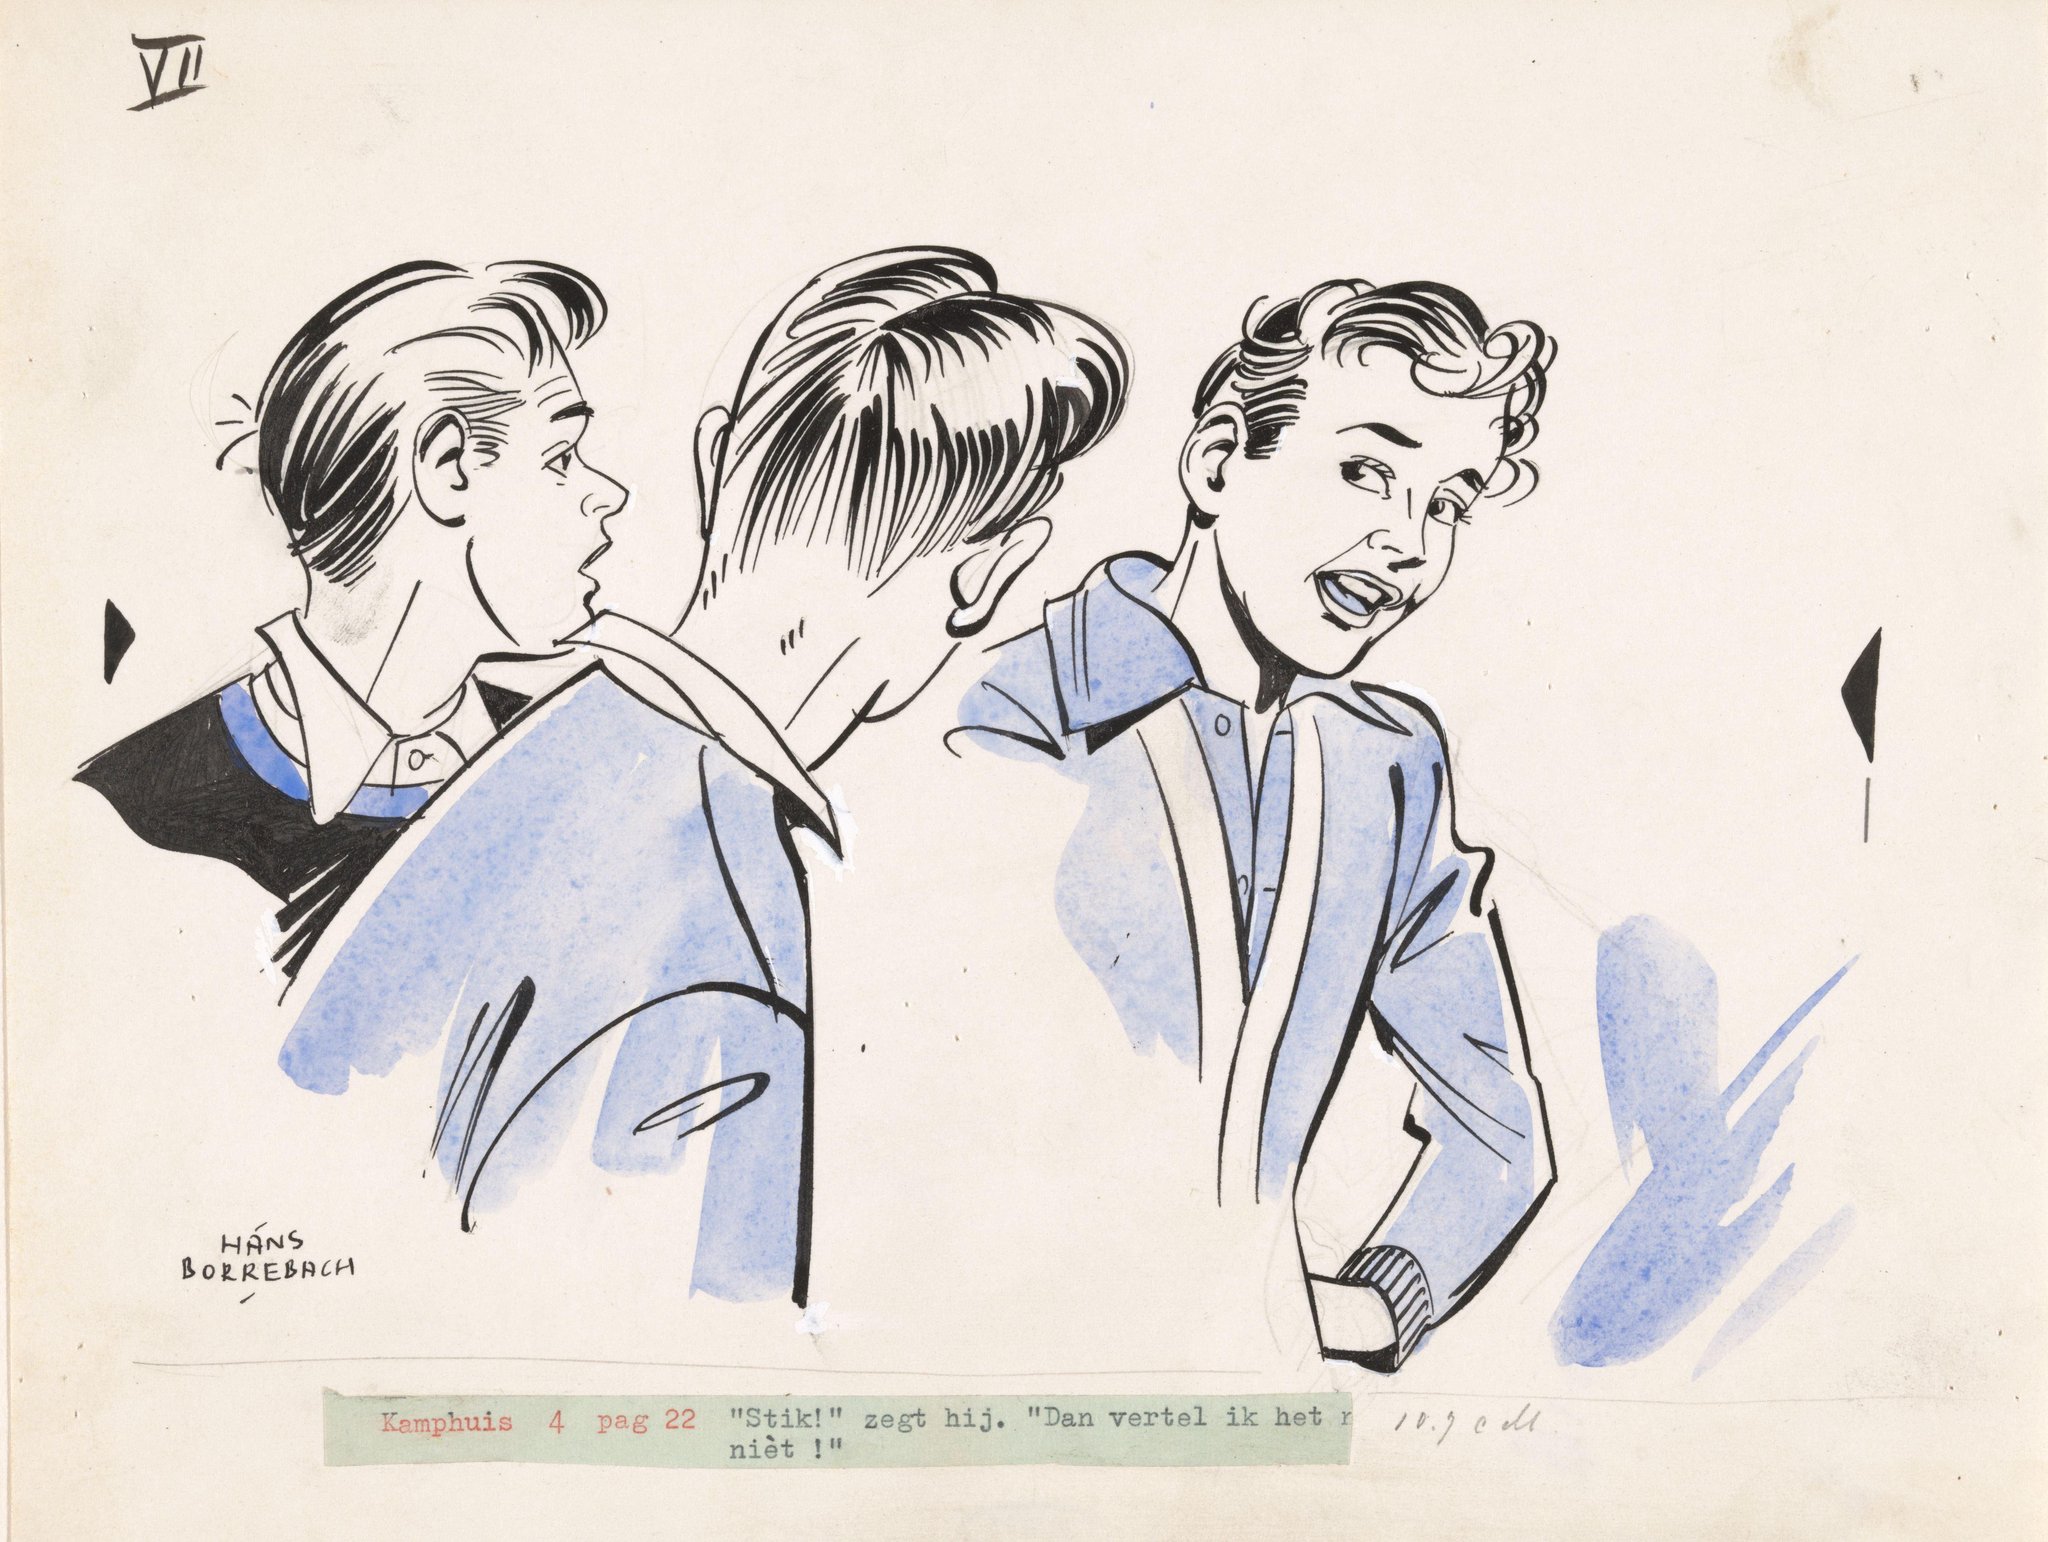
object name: drawing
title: Jongen spreekt tegen twee jongens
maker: hans borrebach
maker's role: draughtsman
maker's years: 1903-1991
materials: paint, ink, paper, pencil, watercolor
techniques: brush, pen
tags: boy (child between toddler and youth), speaking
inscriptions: :, signature: ‘HANS/ BORREBACH’, collector's mark: Lugt 2228a, annotation: ‘KAMPHUIS 4 pag 22 "Stik!" zegt hij. "Dan vertel ik het r/ niet!"’, number: ‘VII’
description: Ontwerp voor: Baljé, J.P. Het kamphuis in de duinen. Amsterdam: Veen, 1953.